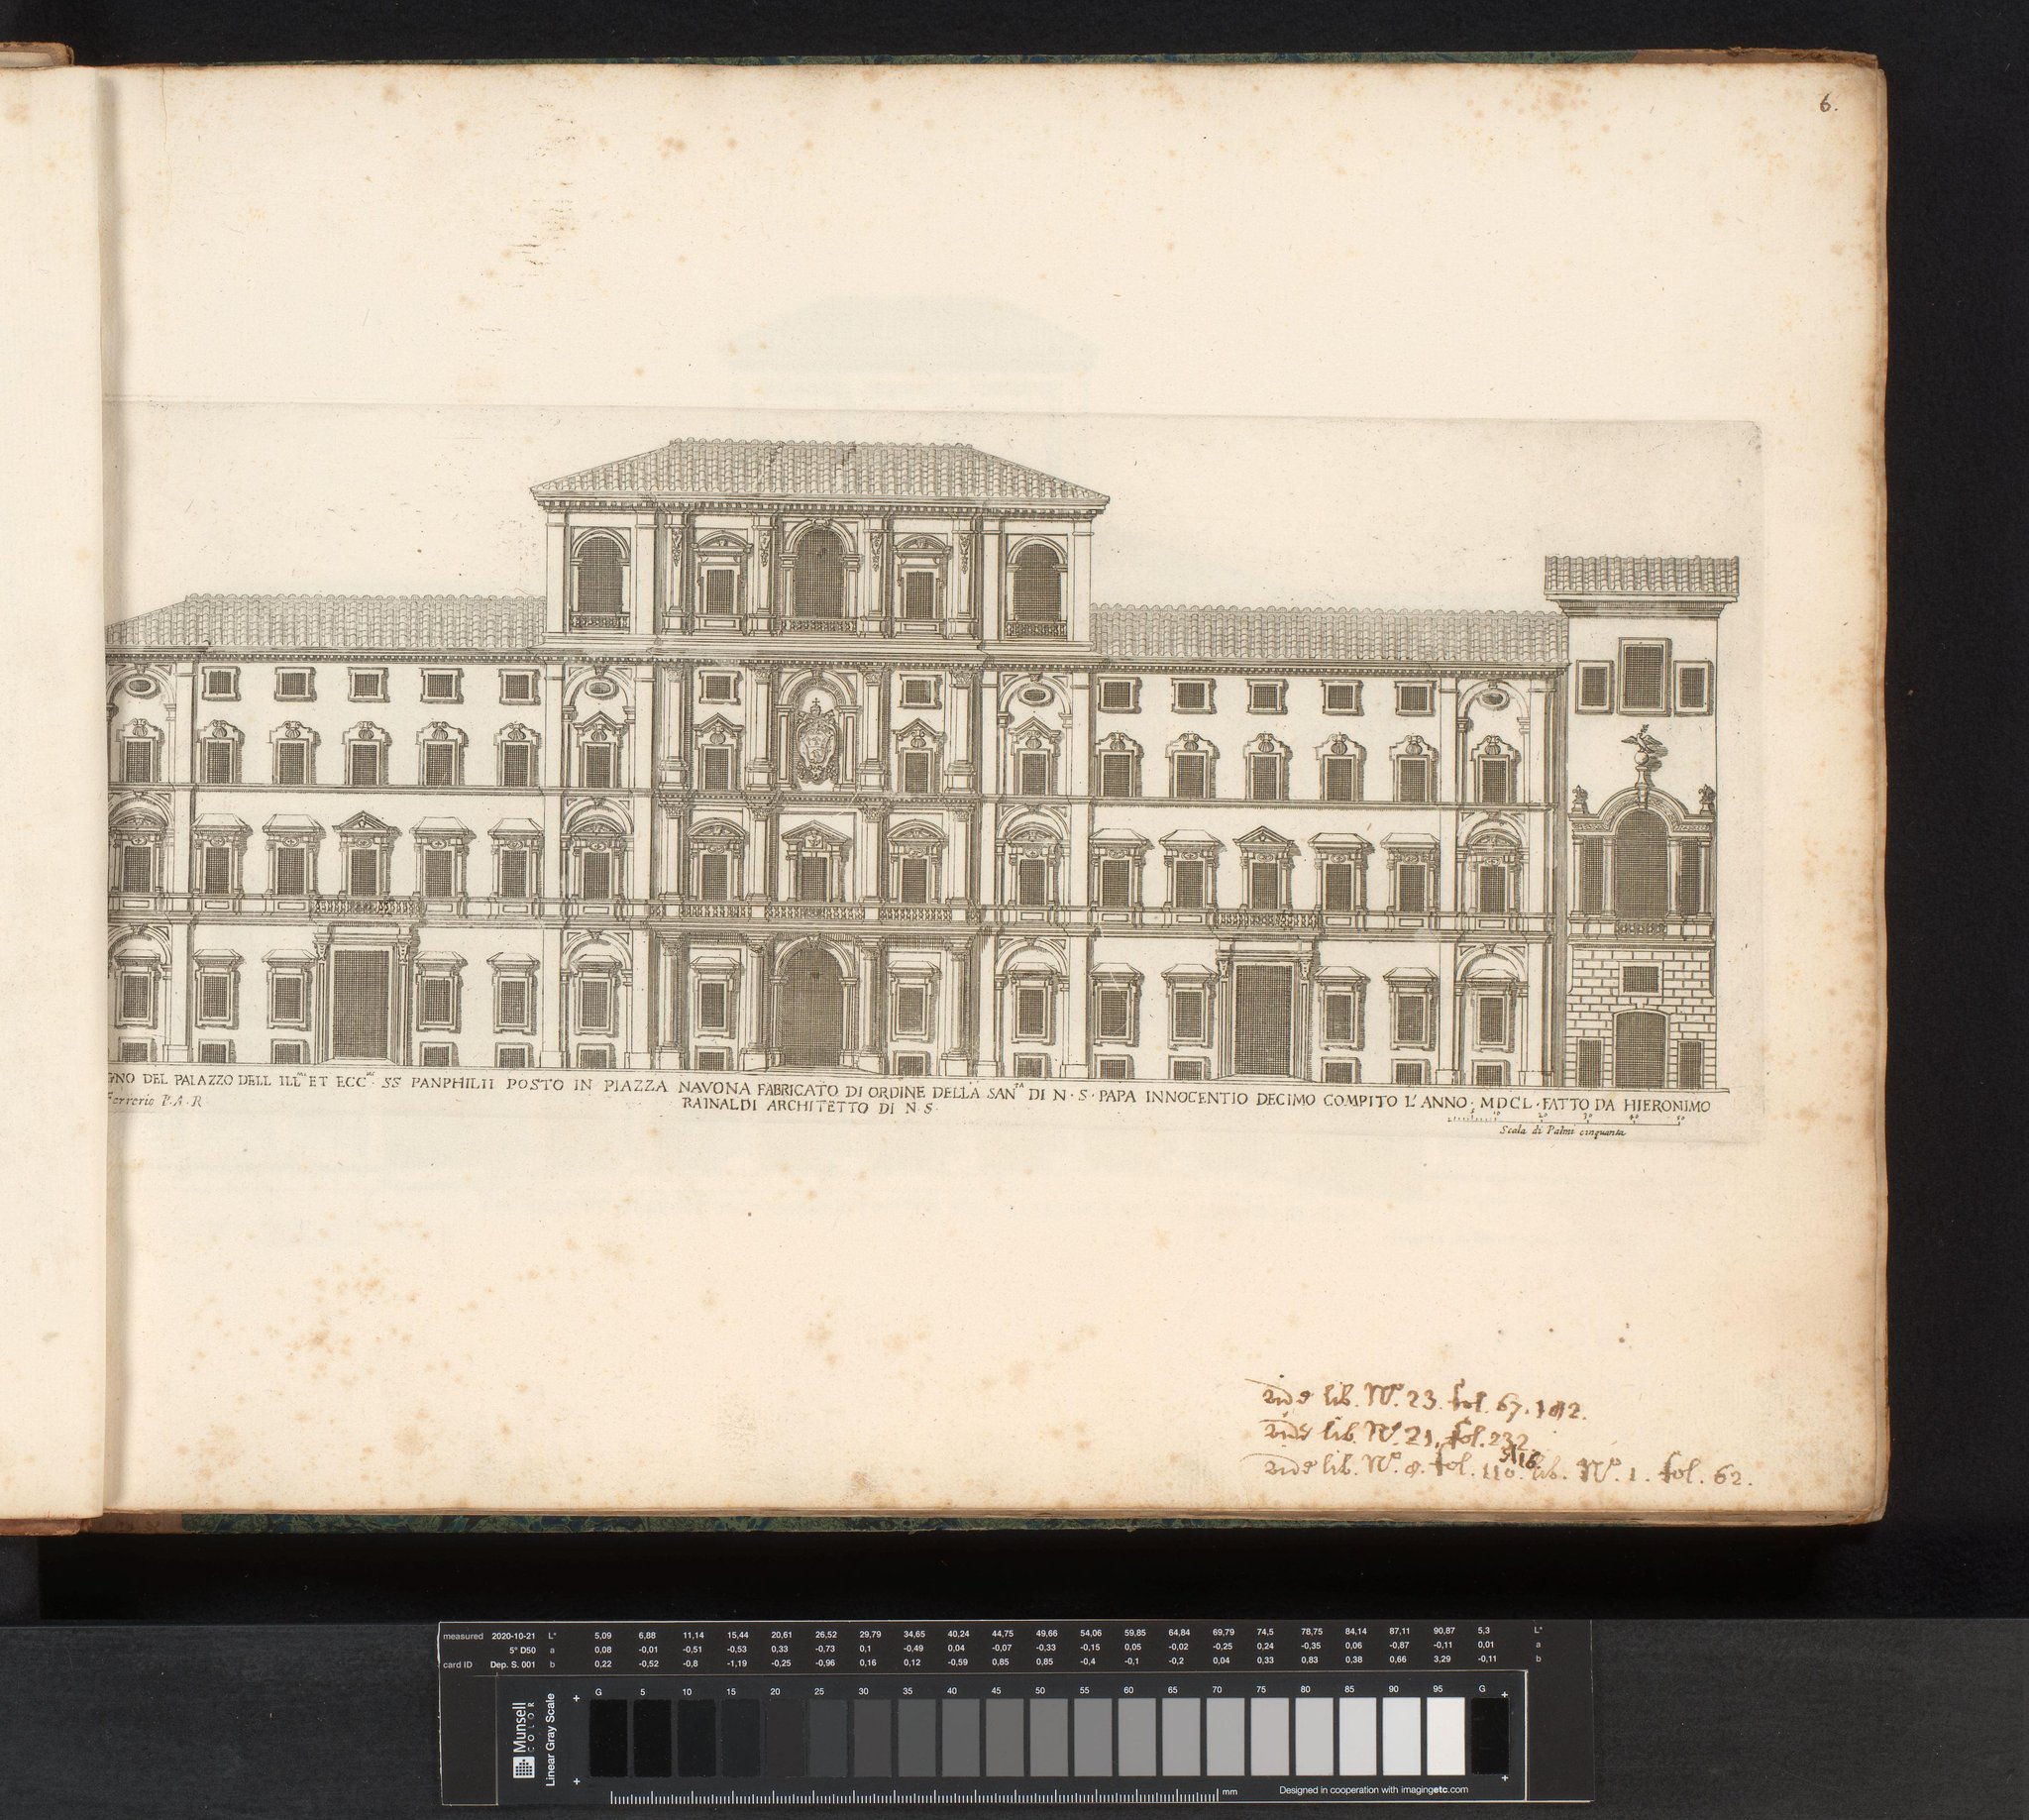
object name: album leaf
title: Façade van Palazzo Doria Pamphilj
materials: paper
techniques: etching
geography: italy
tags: innocentius x, palace, façade (of house or building)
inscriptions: inscription: ‘Ende lib. No. 23. fol. 67. 182./ Ende lib. No. 21. fol. 232...’, number: ‘6’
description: Deze prent maakt deel uit van de reeks getiteld: Palazzi di Roma. Deze reeks bestaat uit twee boeken. Boek één getiteld: Palazzi di Roma dei più celebri architetti..., bestaat uit 44 prenten die worden toegeschreven aan Giovanni Battista Falda (naam staat enkel op prent 27) en uitgegeven door Giovanni Giacomo de'Rossi. Deze 44 prenten zijn bekend in twee staten (met en zonder nummer). Boek twee getiteld: Nuovi disegni dell'architetture... libro secondo, bevat 66 prenten door Giovanni Battista Falda en Simone Felice. Deze 66 prenten zijn bekend in twee staten (met en zonder nummer).